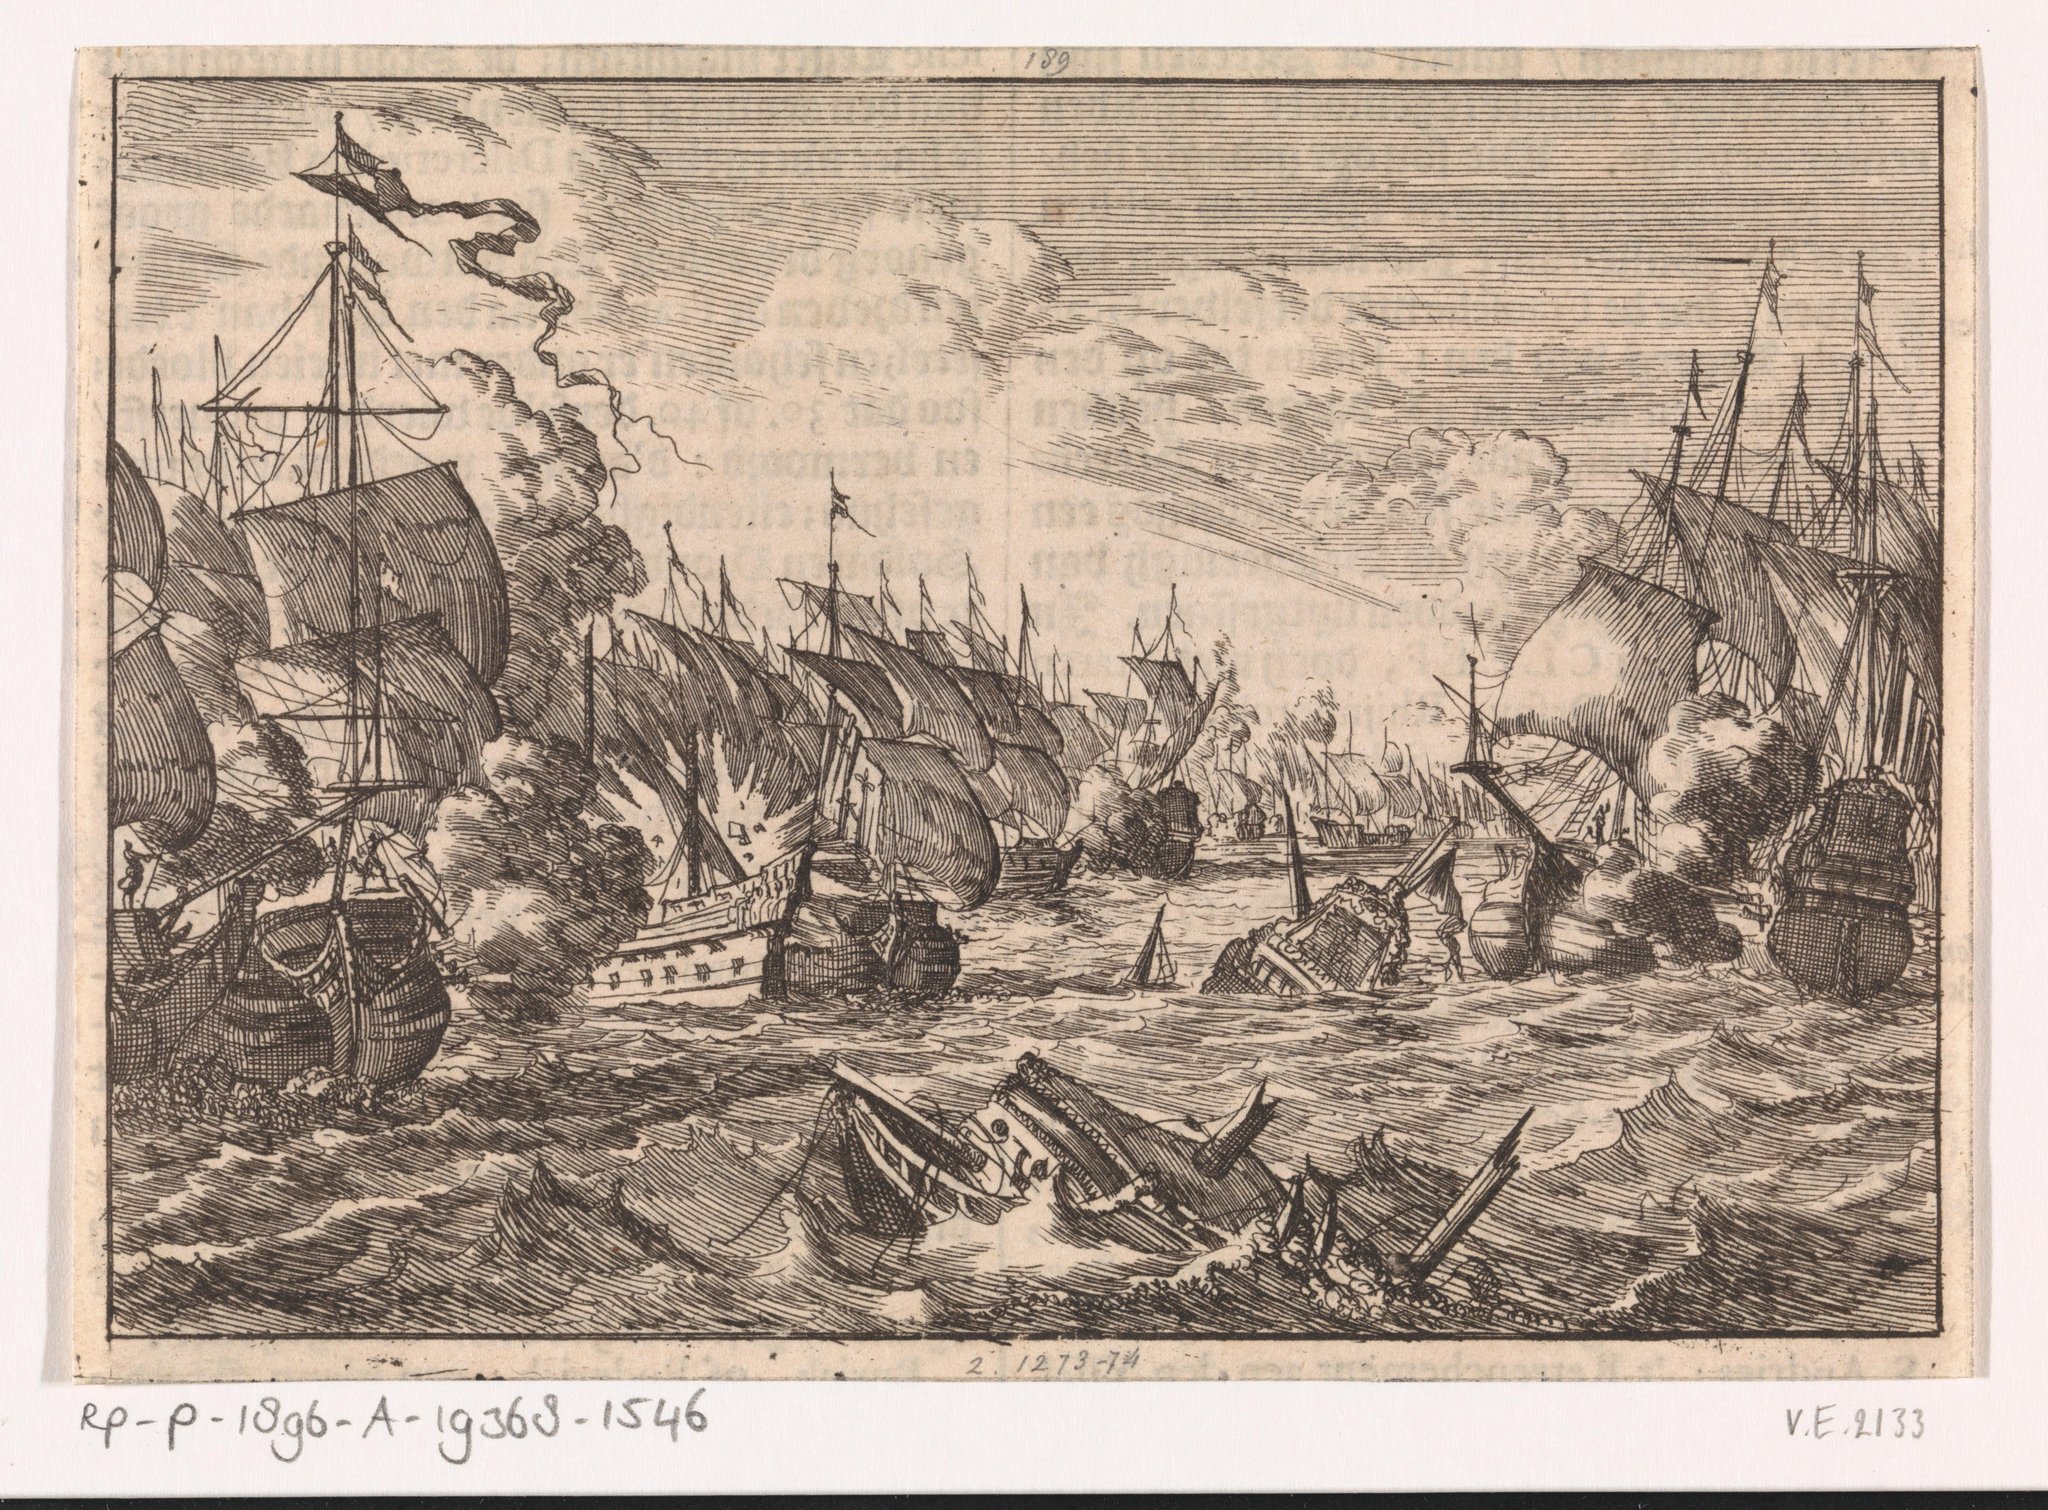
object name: book illustration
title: Slag bij Solebay, 1672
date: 1698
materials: paper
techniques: etching, letterpress printing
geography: amsterdam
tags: battle (+ naval force), battle of solebay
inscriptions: collector's mark: Lugt 2228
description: Illustratie uit: Gottfried, Johann Ludwig. Historische kronyck; vervattende een (...) beschrijvingh der aldergedenckwaerdigste geschiedenissen des weerelds, van den aenvangh der scheppingh tot (...) 1576 (2 delen). Leiden: Pieter van der Aa, 1698, dl. II, p. 1273.